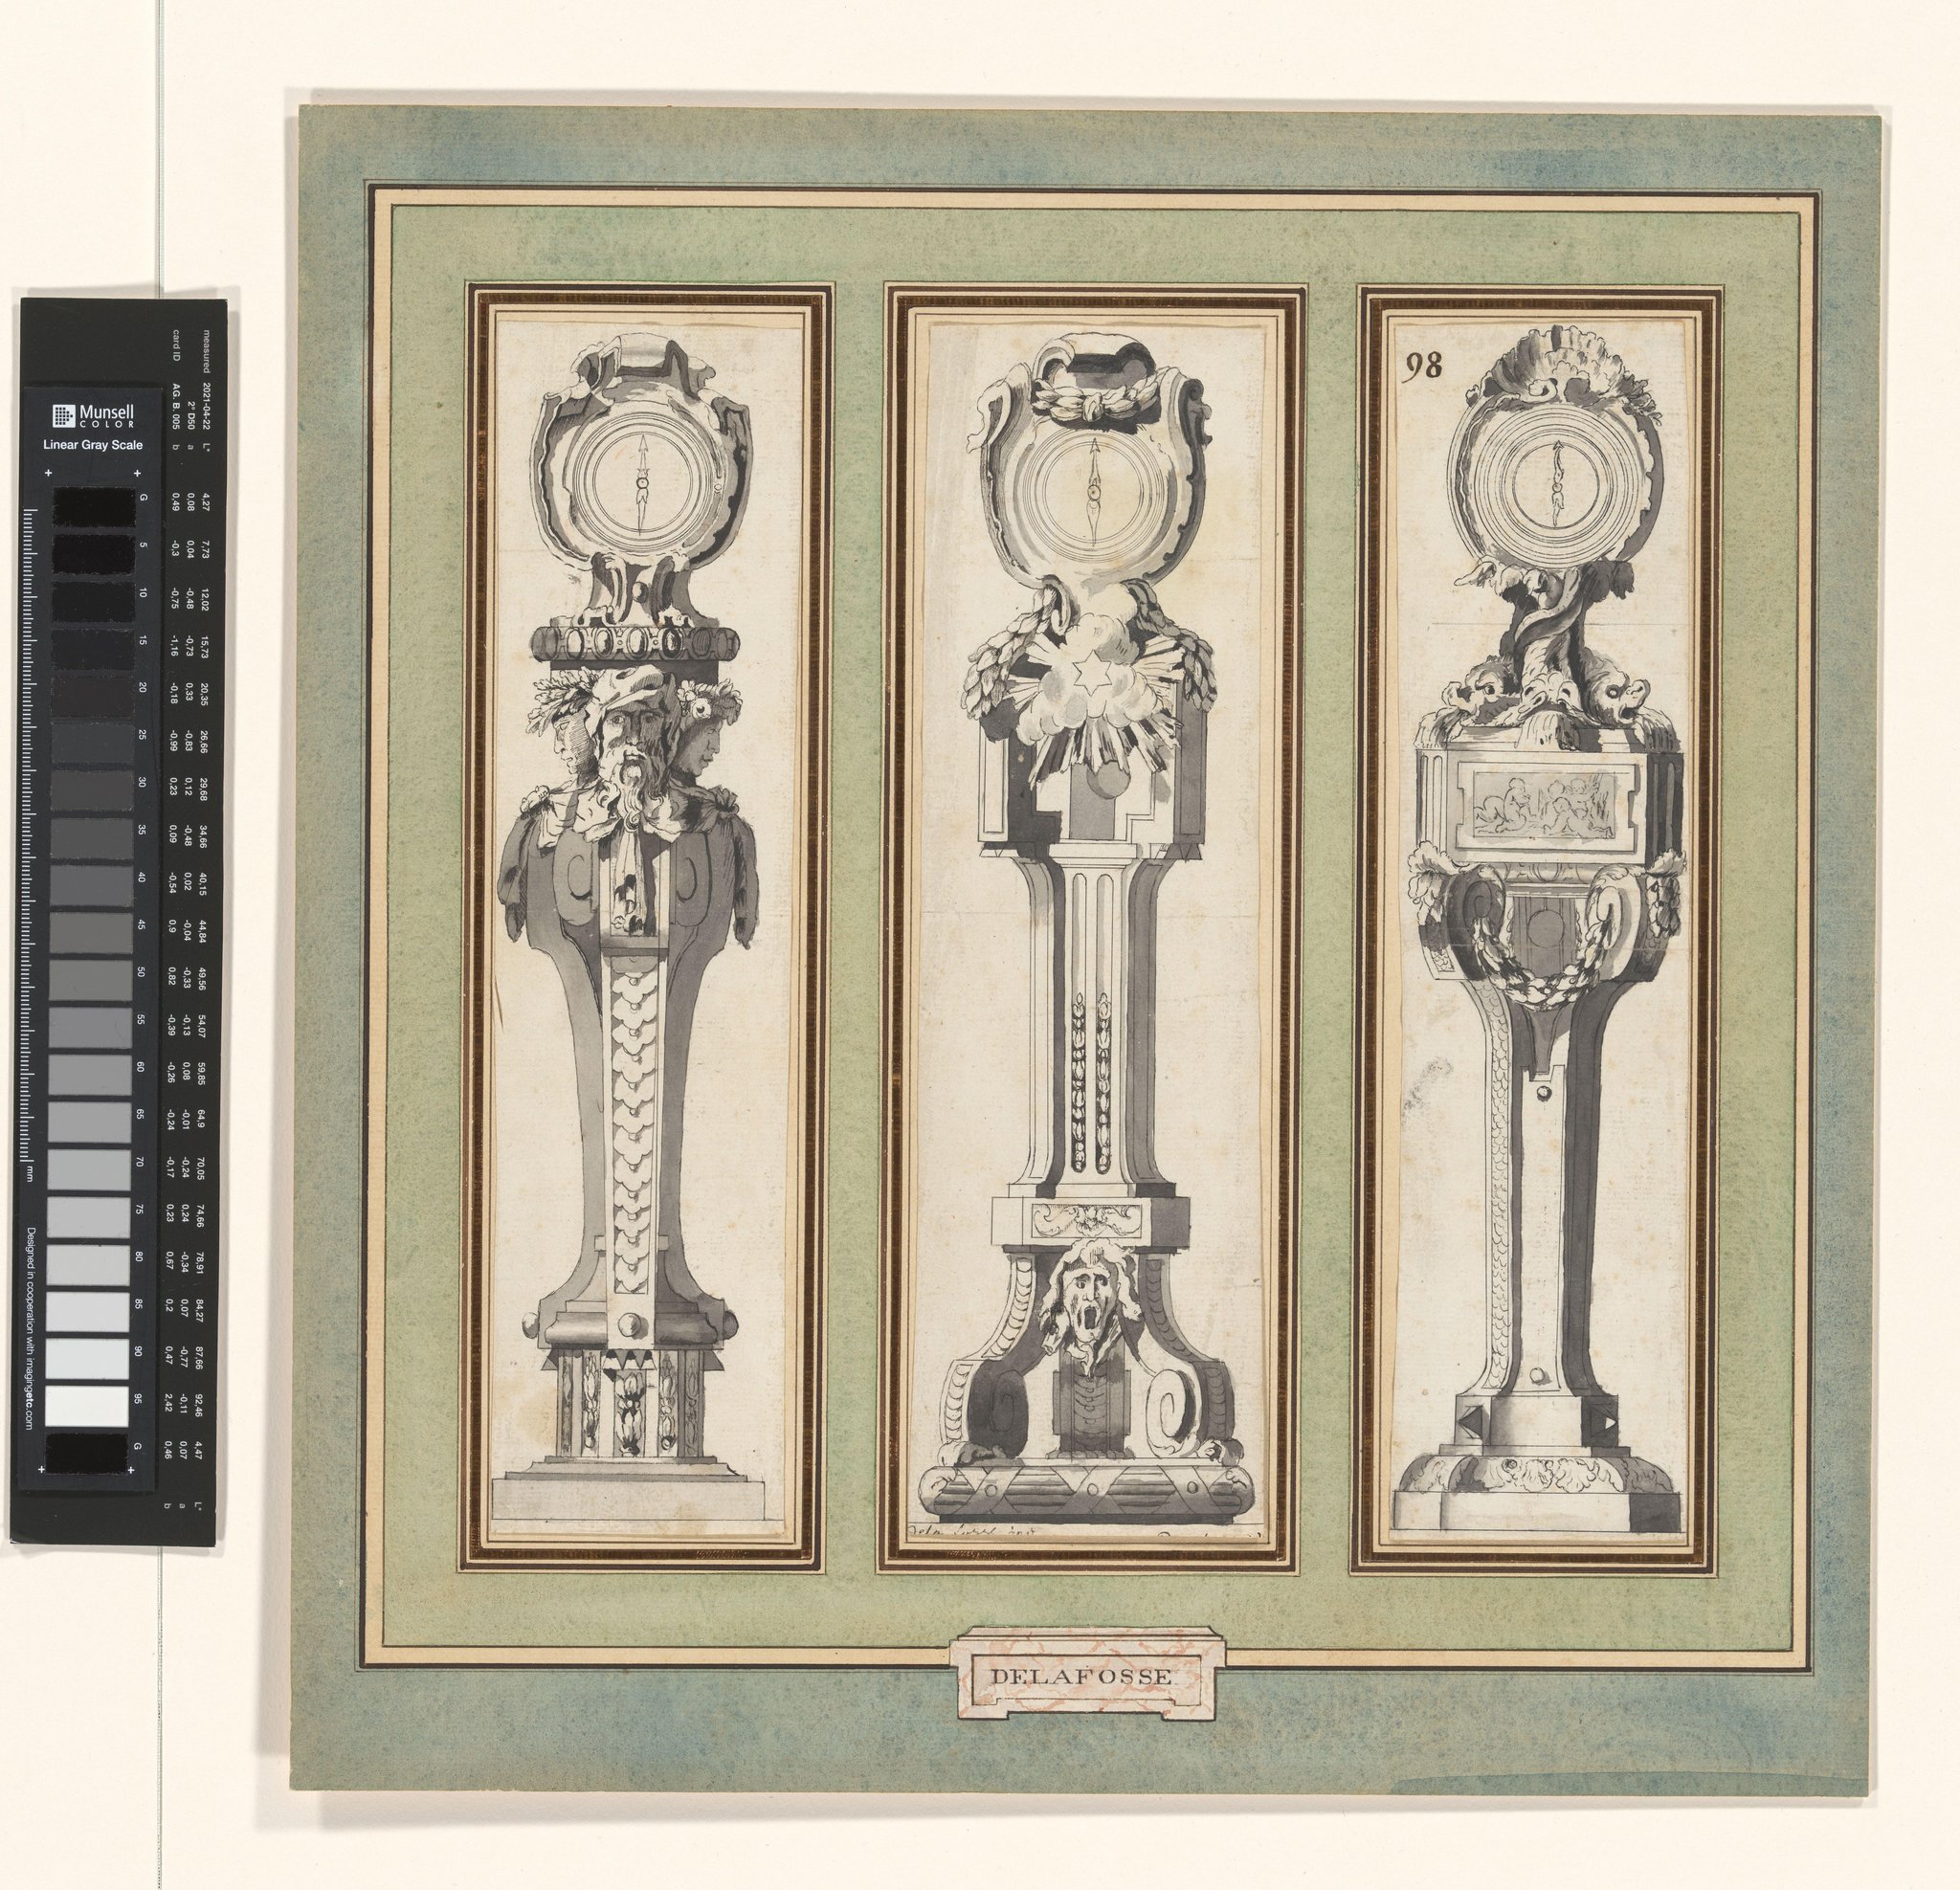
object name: drawing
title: Ontwerp voor de kast van een staand horloge, met drie maskers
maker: jean charles delafosse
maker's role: print maker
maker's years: 1734-1791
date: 1770-1775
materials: ink, paper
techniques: brush, pen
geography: paris